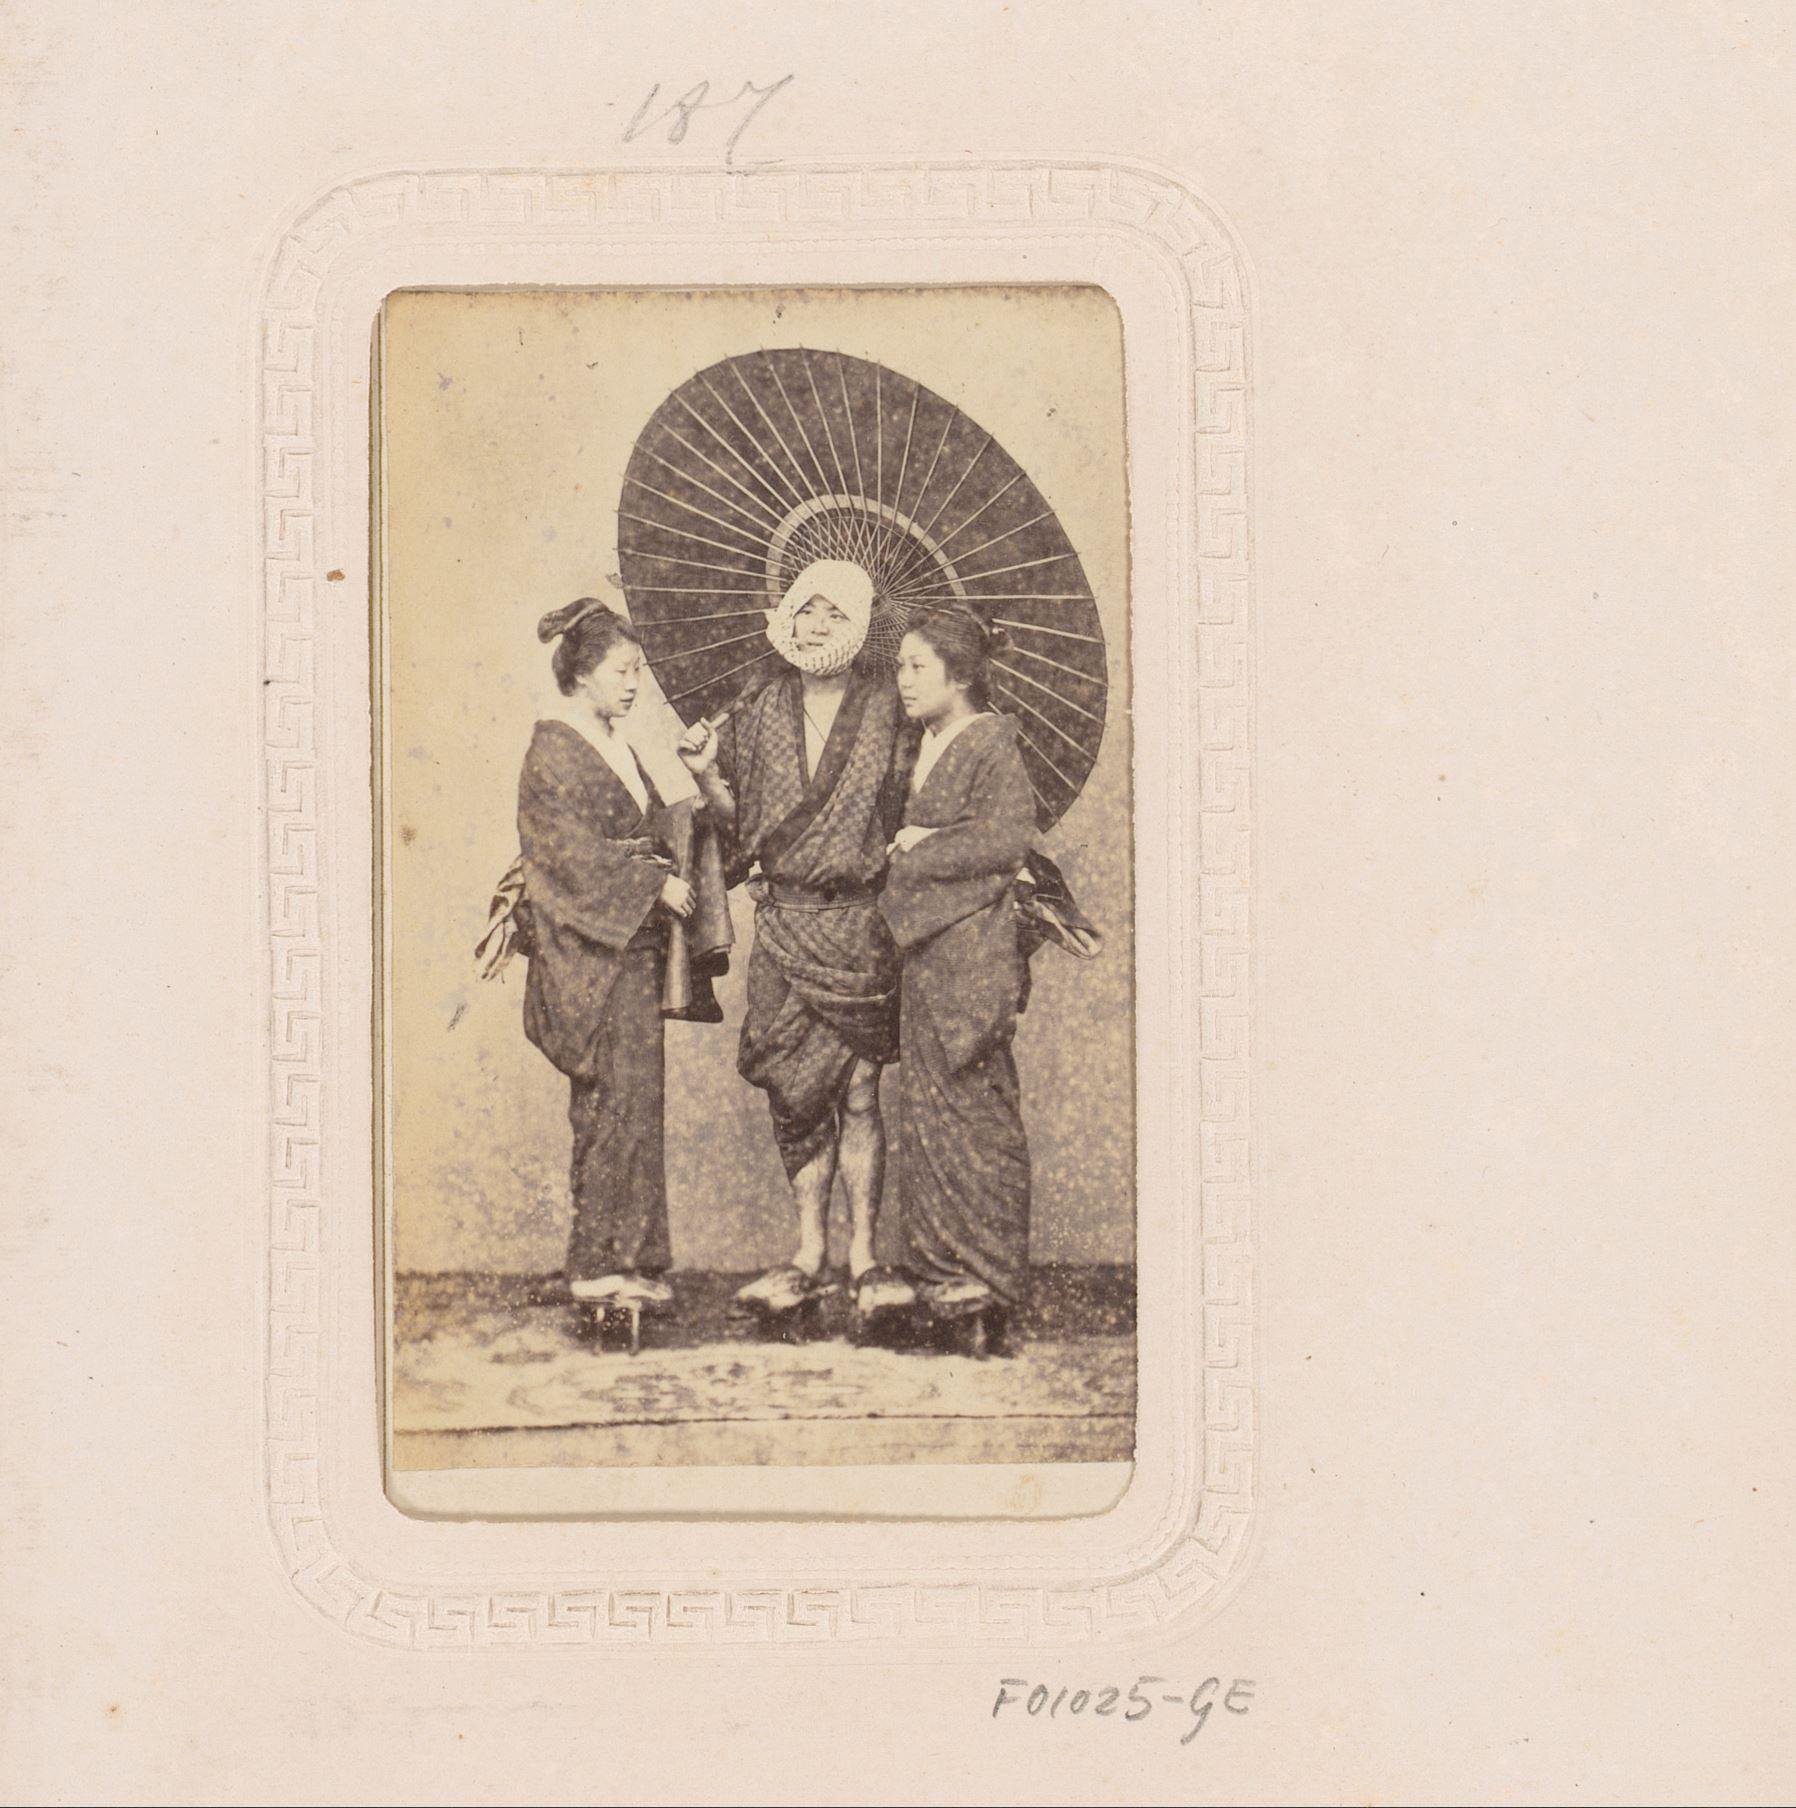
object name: carte de visite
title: Portret van twee Japanse vrouwen en een man met parasol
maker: Anonymous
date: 1850-1880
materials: cardboard, photographic support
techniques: albumen print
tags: historical persons - bb - woman, historical persons, umbrella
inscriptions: number: ‘187’